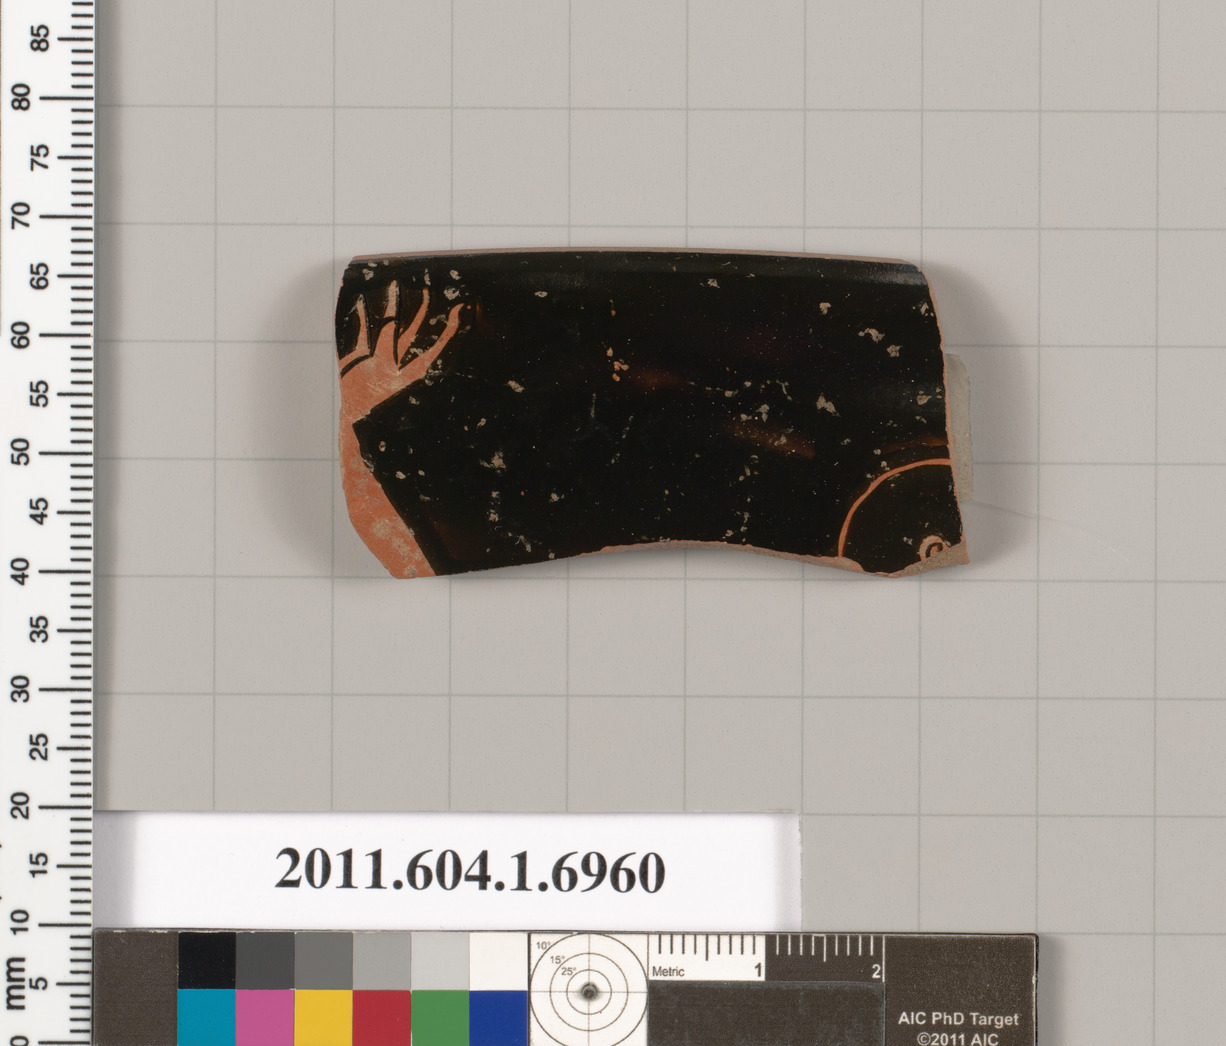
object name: kylix fragment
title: Terracotta rim fragment of a kylix (drinking cup)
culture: greek, attic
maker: painter of the paris gigantomachy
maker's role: artist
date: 490-470 BCE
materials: terracotta